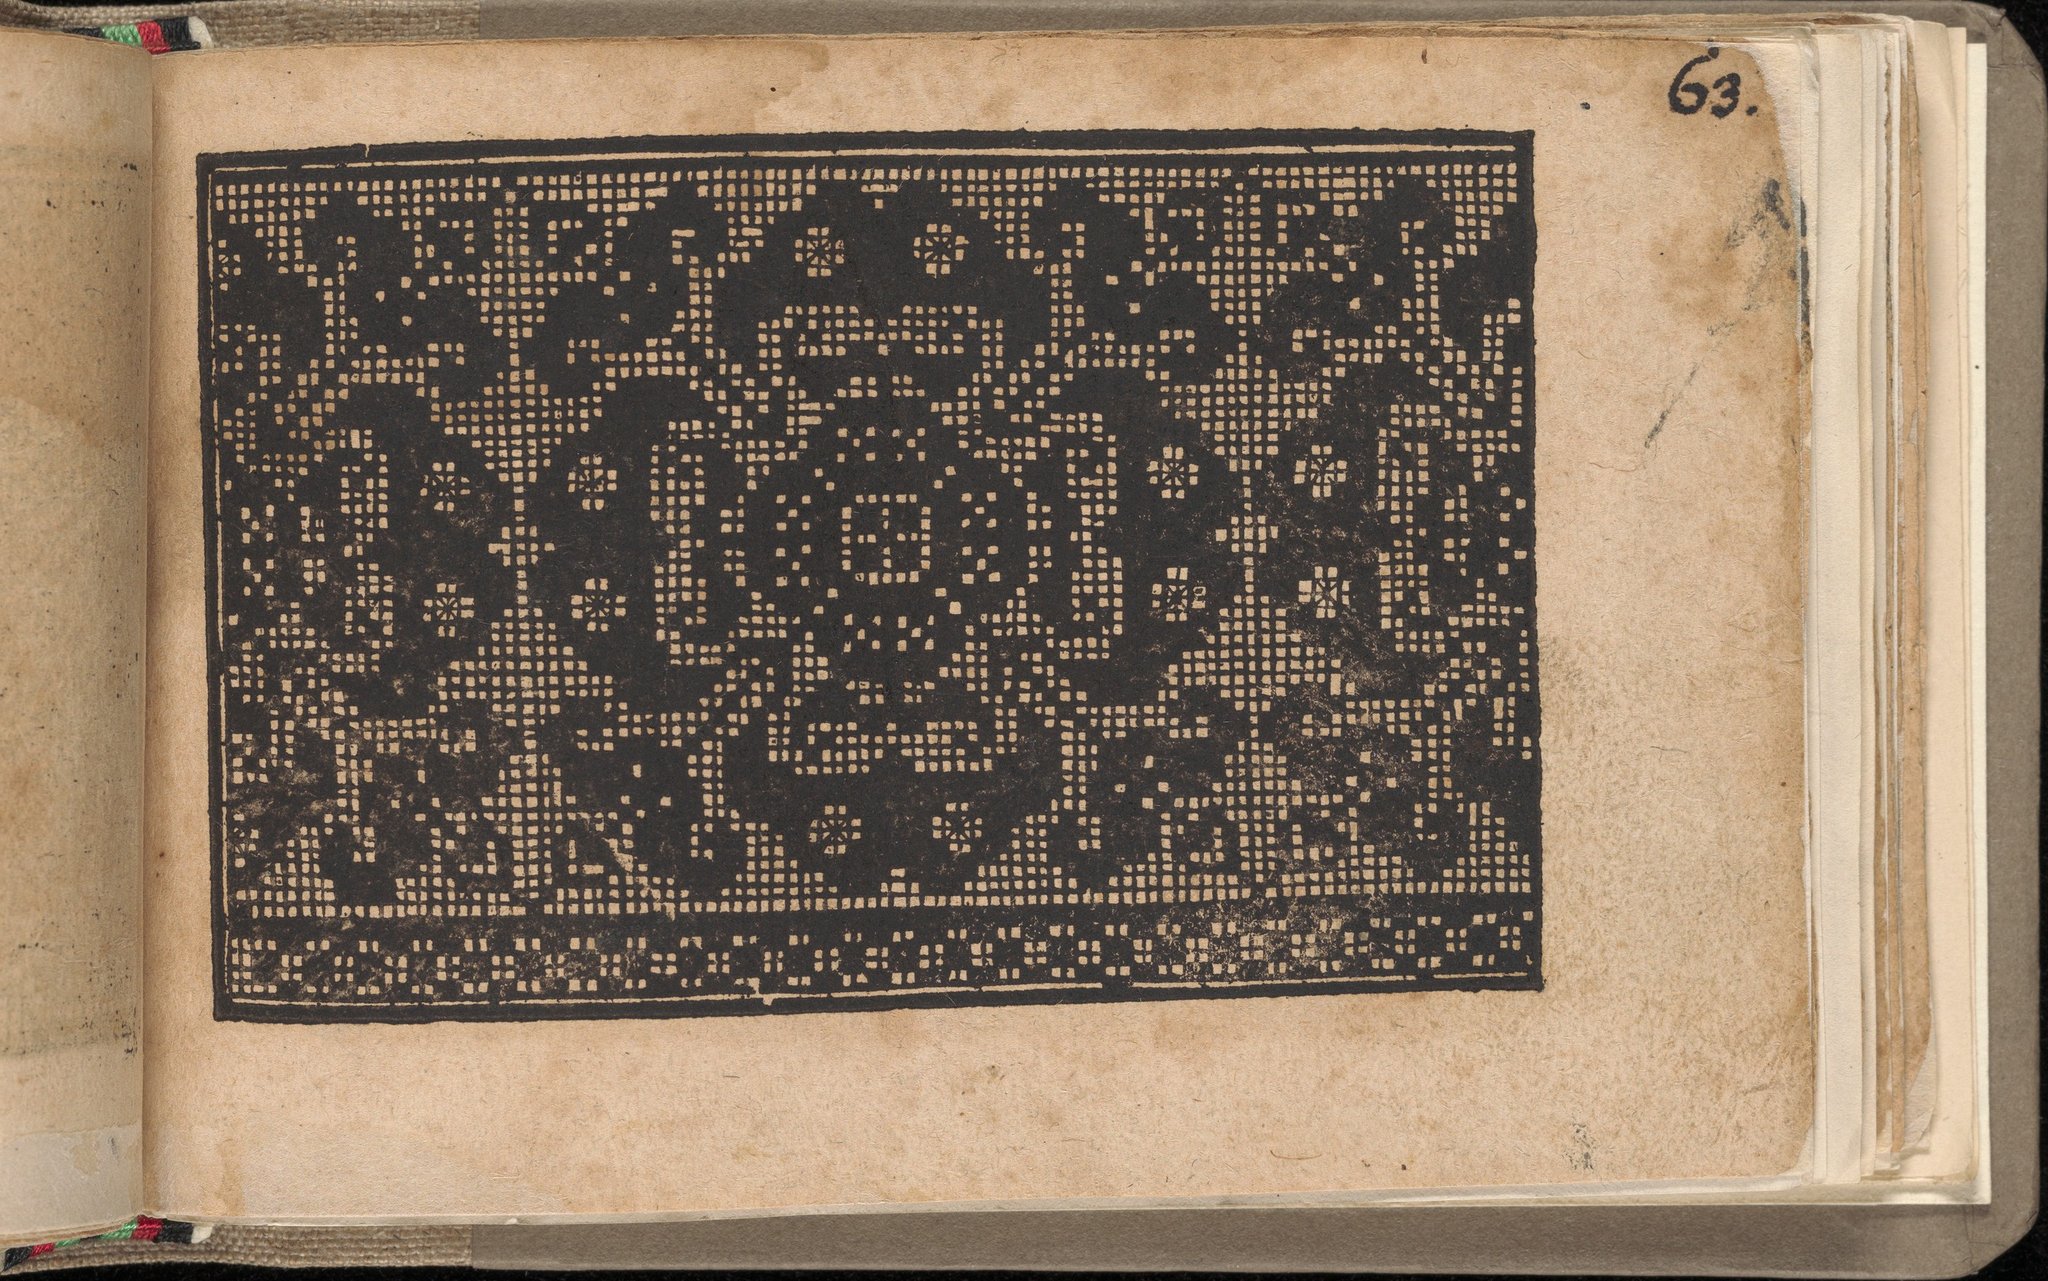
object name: book print ornament architecture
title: Schön newes Modelbuch (Page 63r)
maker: sigismundus latomus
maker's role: publisher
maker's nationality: german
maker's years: 1599-1632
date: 1608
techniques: woodcut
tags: ornament